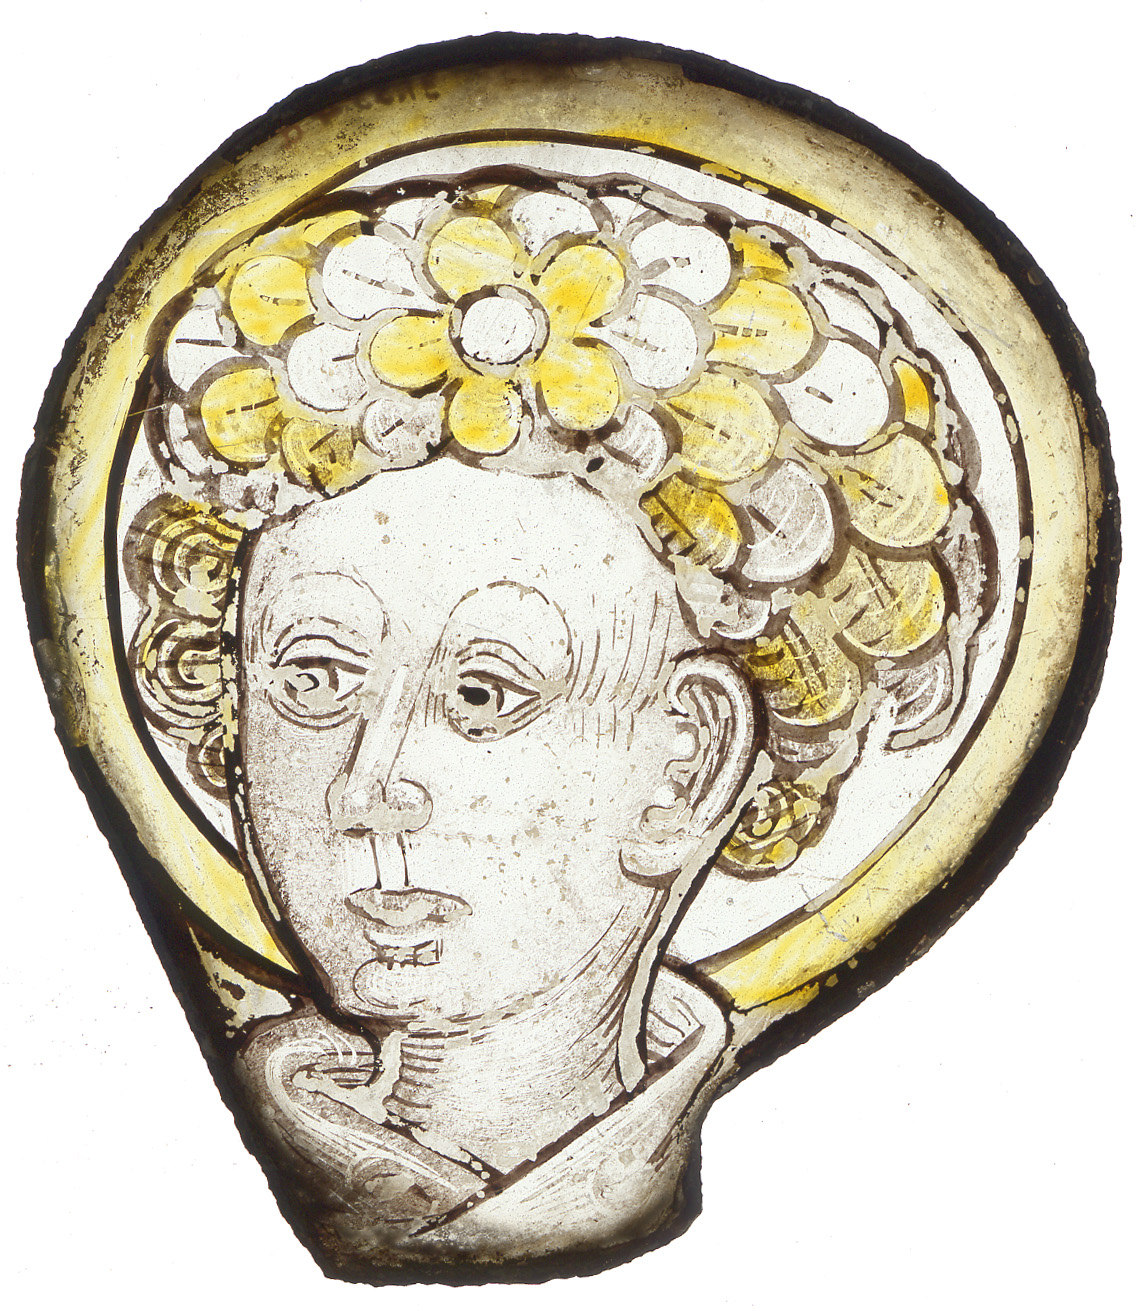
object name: panel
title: Head of a Saint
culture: british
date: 1401-1500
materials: glass, paint, pigment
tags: heads